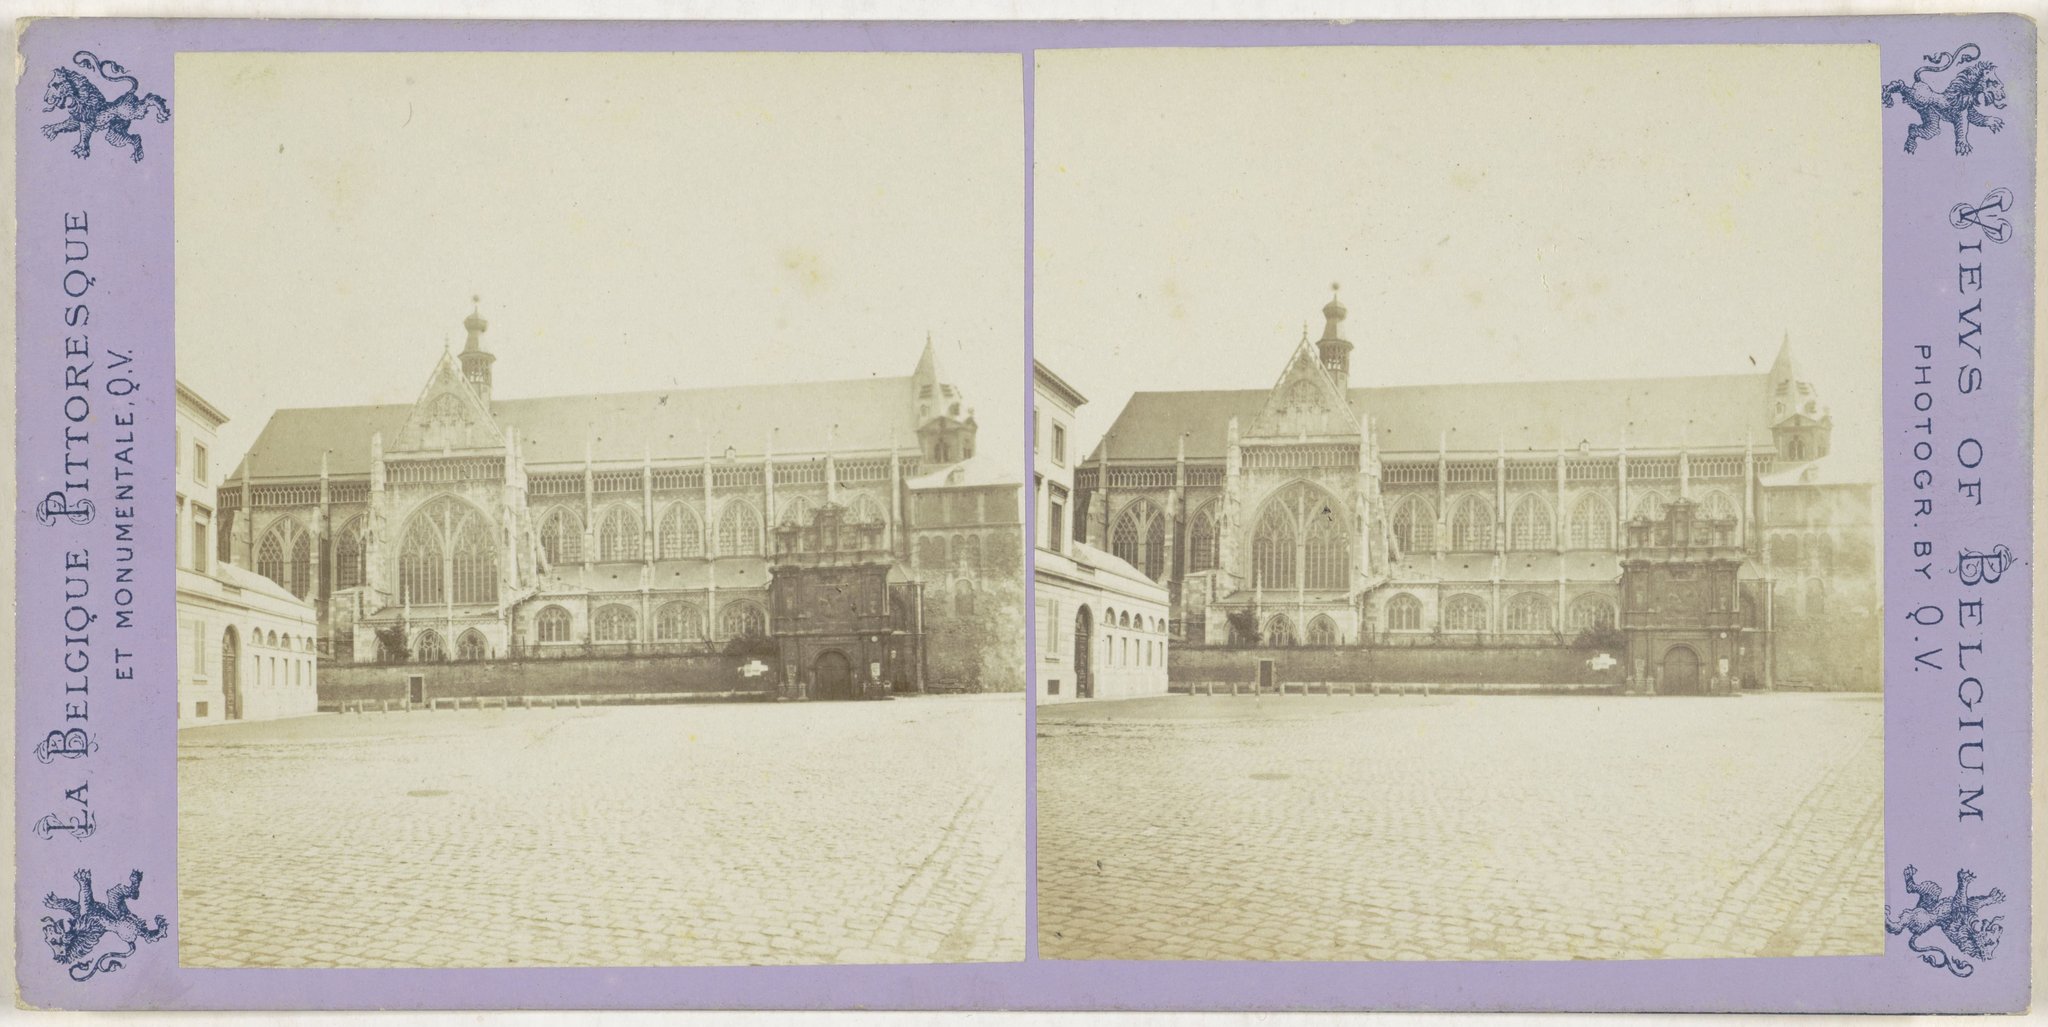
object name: stereograph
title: Gezicht op de Sint-Jacobskerk in Luik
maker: jules hippolyte quéval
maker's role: publisher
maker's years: 1824-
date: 1866-1870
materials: cardboard, paper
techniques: albumen print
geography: liège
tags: church (exterior)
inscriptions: number: ‘No 1861’